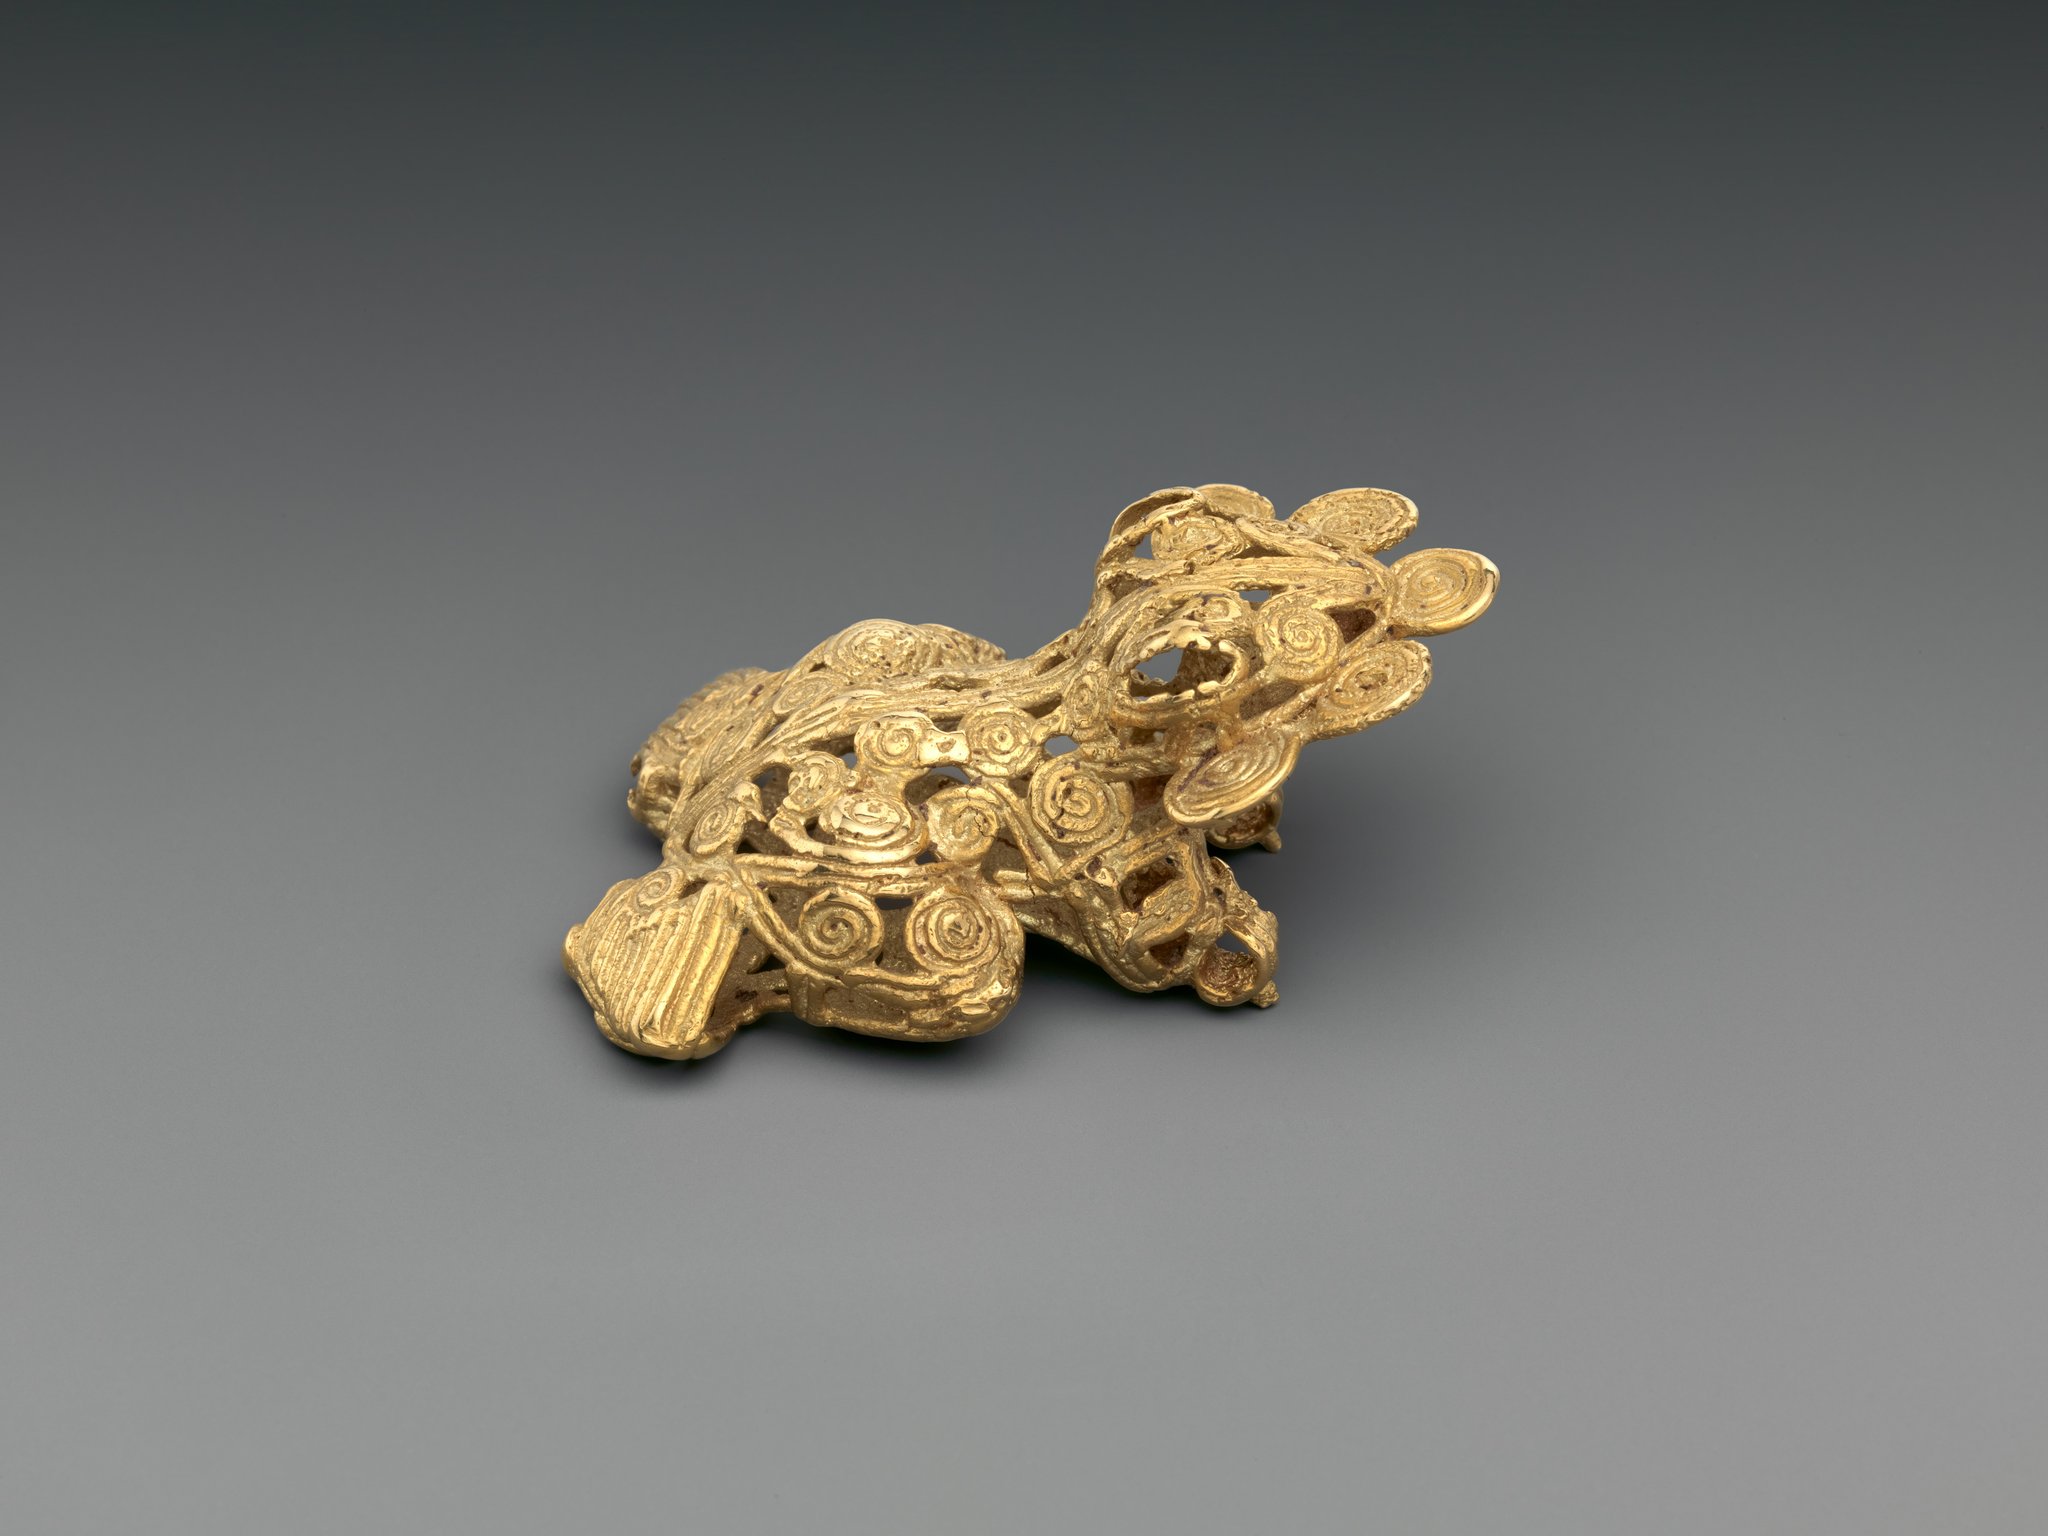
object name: pendant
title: Frog Pendant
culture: venado beach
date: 401-800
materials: gold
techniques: casting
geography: panama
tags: frogs